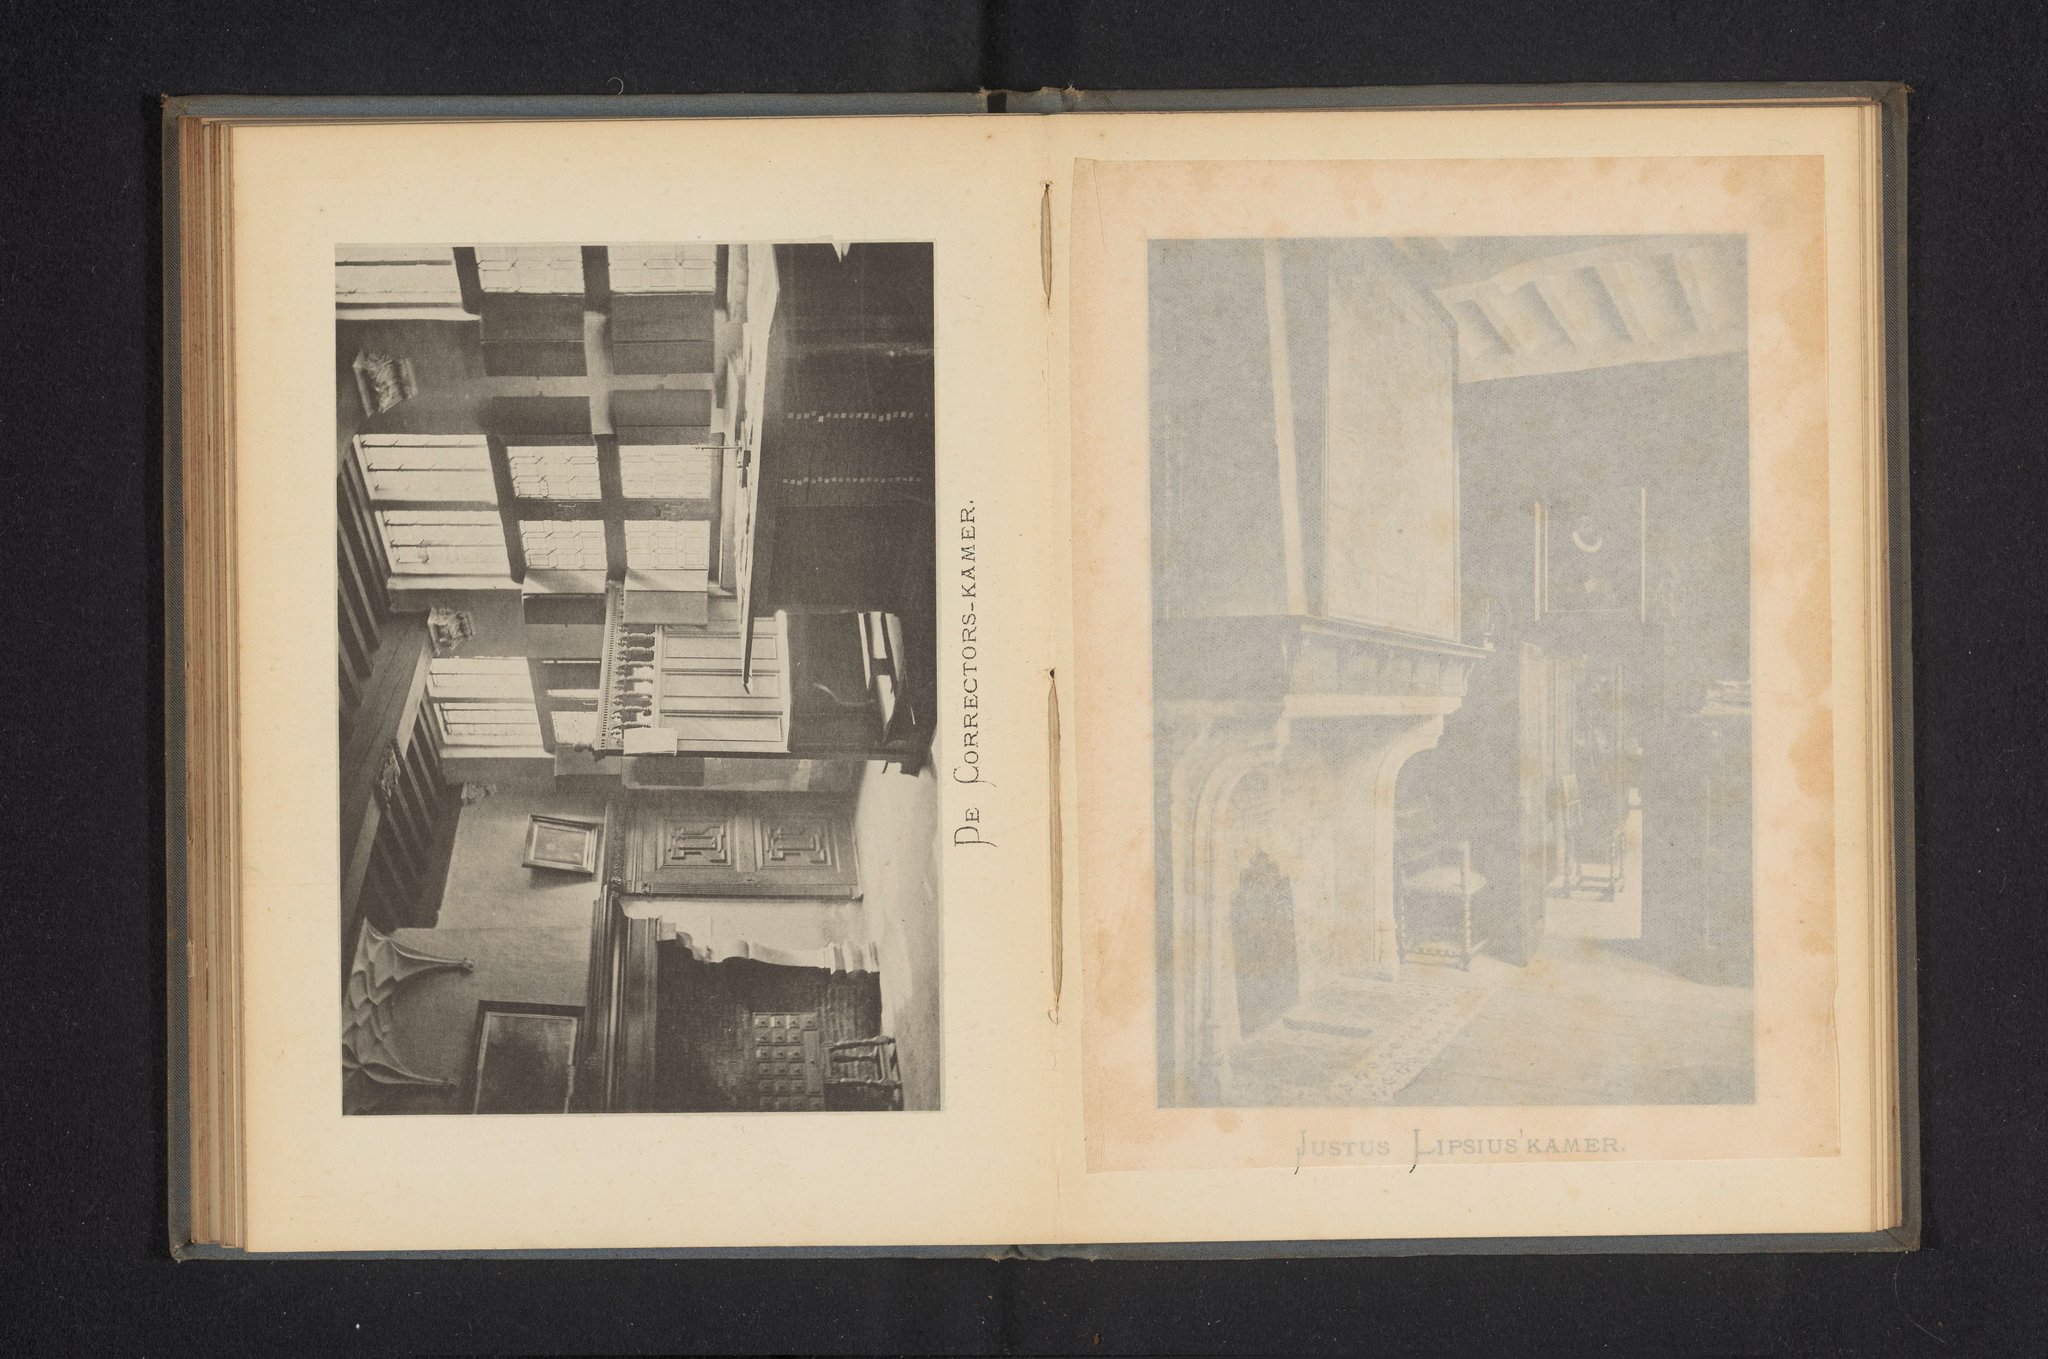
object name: page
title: Interieur van de correctors kamer het huis van Christoffel Plantijn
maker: joseph maes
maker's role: fotograaf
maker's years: 1838-1908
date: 1881-1886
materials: paper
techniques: photograph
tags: interior of the house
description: Prent op tweede ongenummerde pagina na pagina 120.